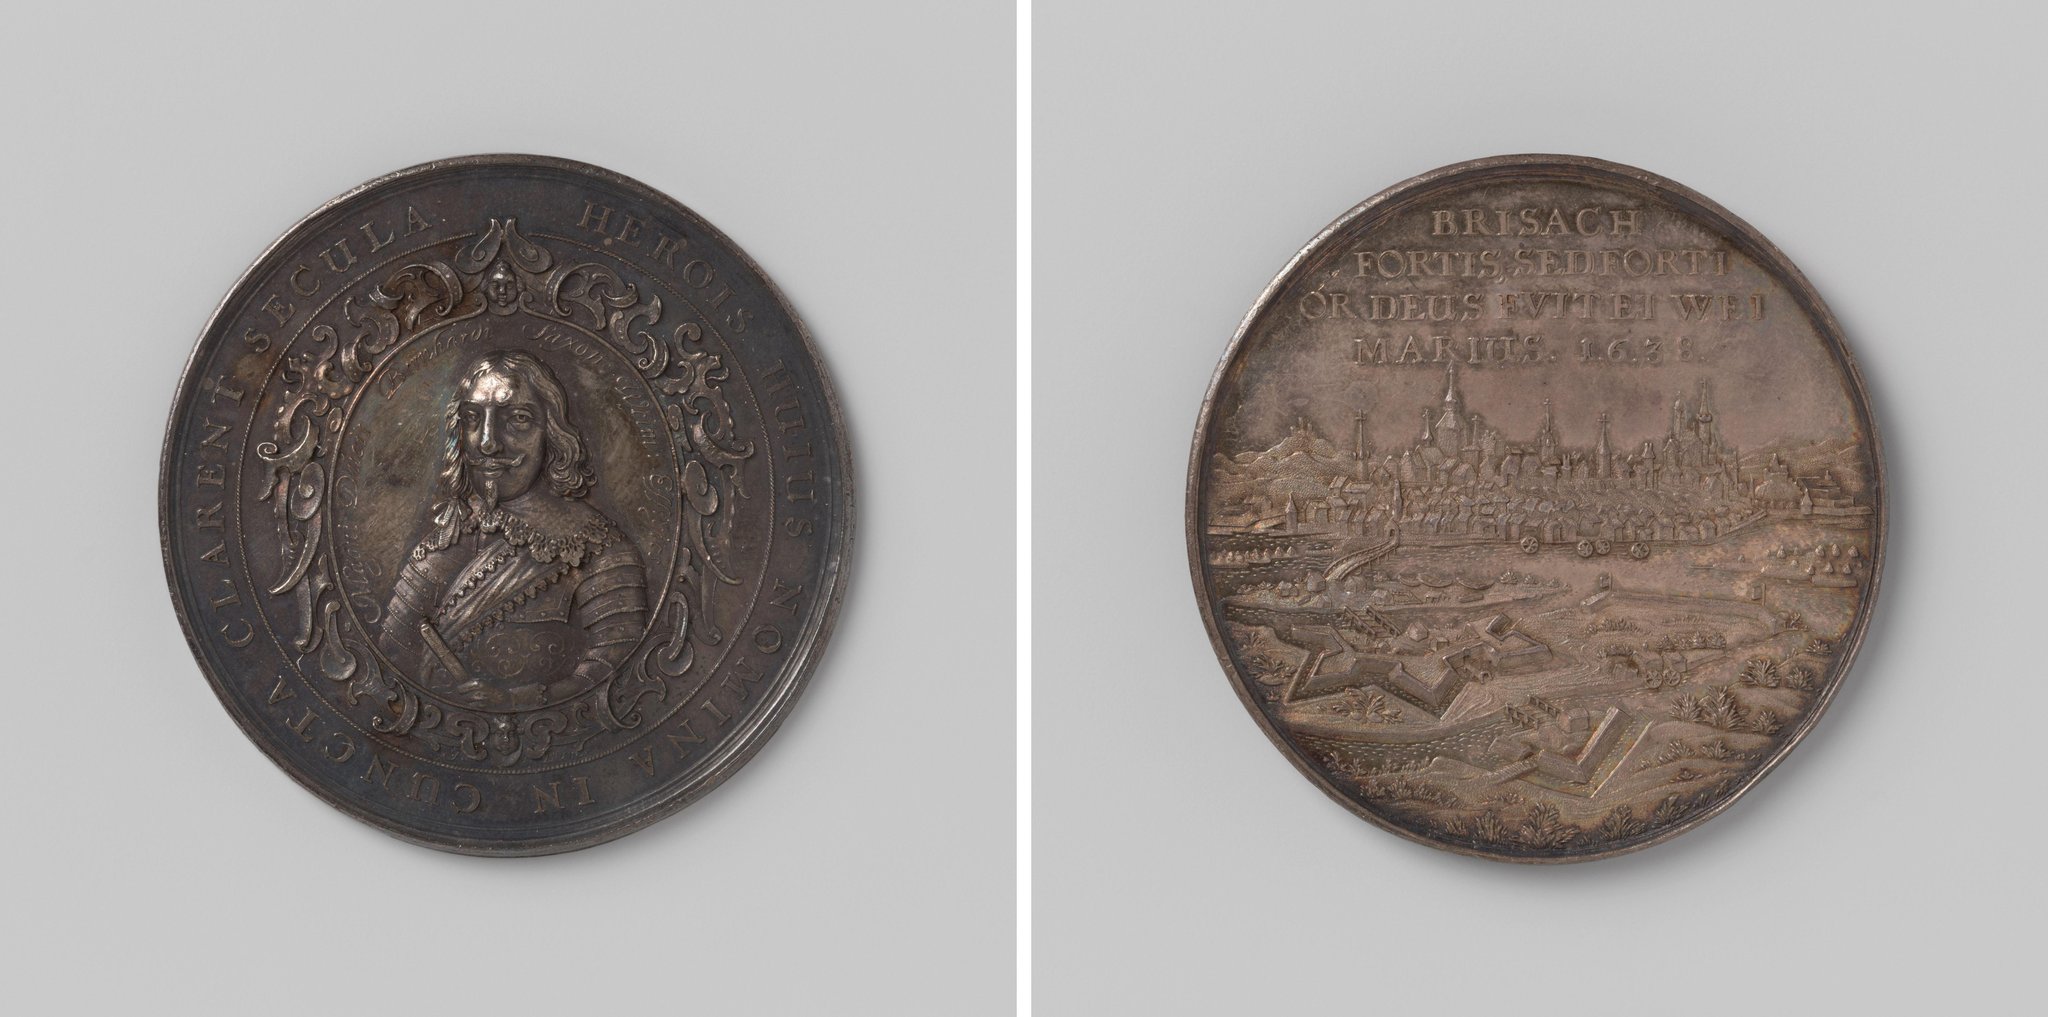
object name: history medal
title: Inname van Breisach door Bernhard van Saksen-Weimar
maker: johann blum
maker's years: 1599-1668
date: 1638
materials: silver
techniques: striking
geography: bremen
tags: weimar, baden-württemberg, generaal, bernhard (hertog van saksen-weimar), breisach, inname van breisach (1638)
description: Zilveren penning. Voorzijde: borststuk man binnen cartouche en omschrift. Keerzijde: gezicht op stad Breisach en vestingwerken onder opschrift.